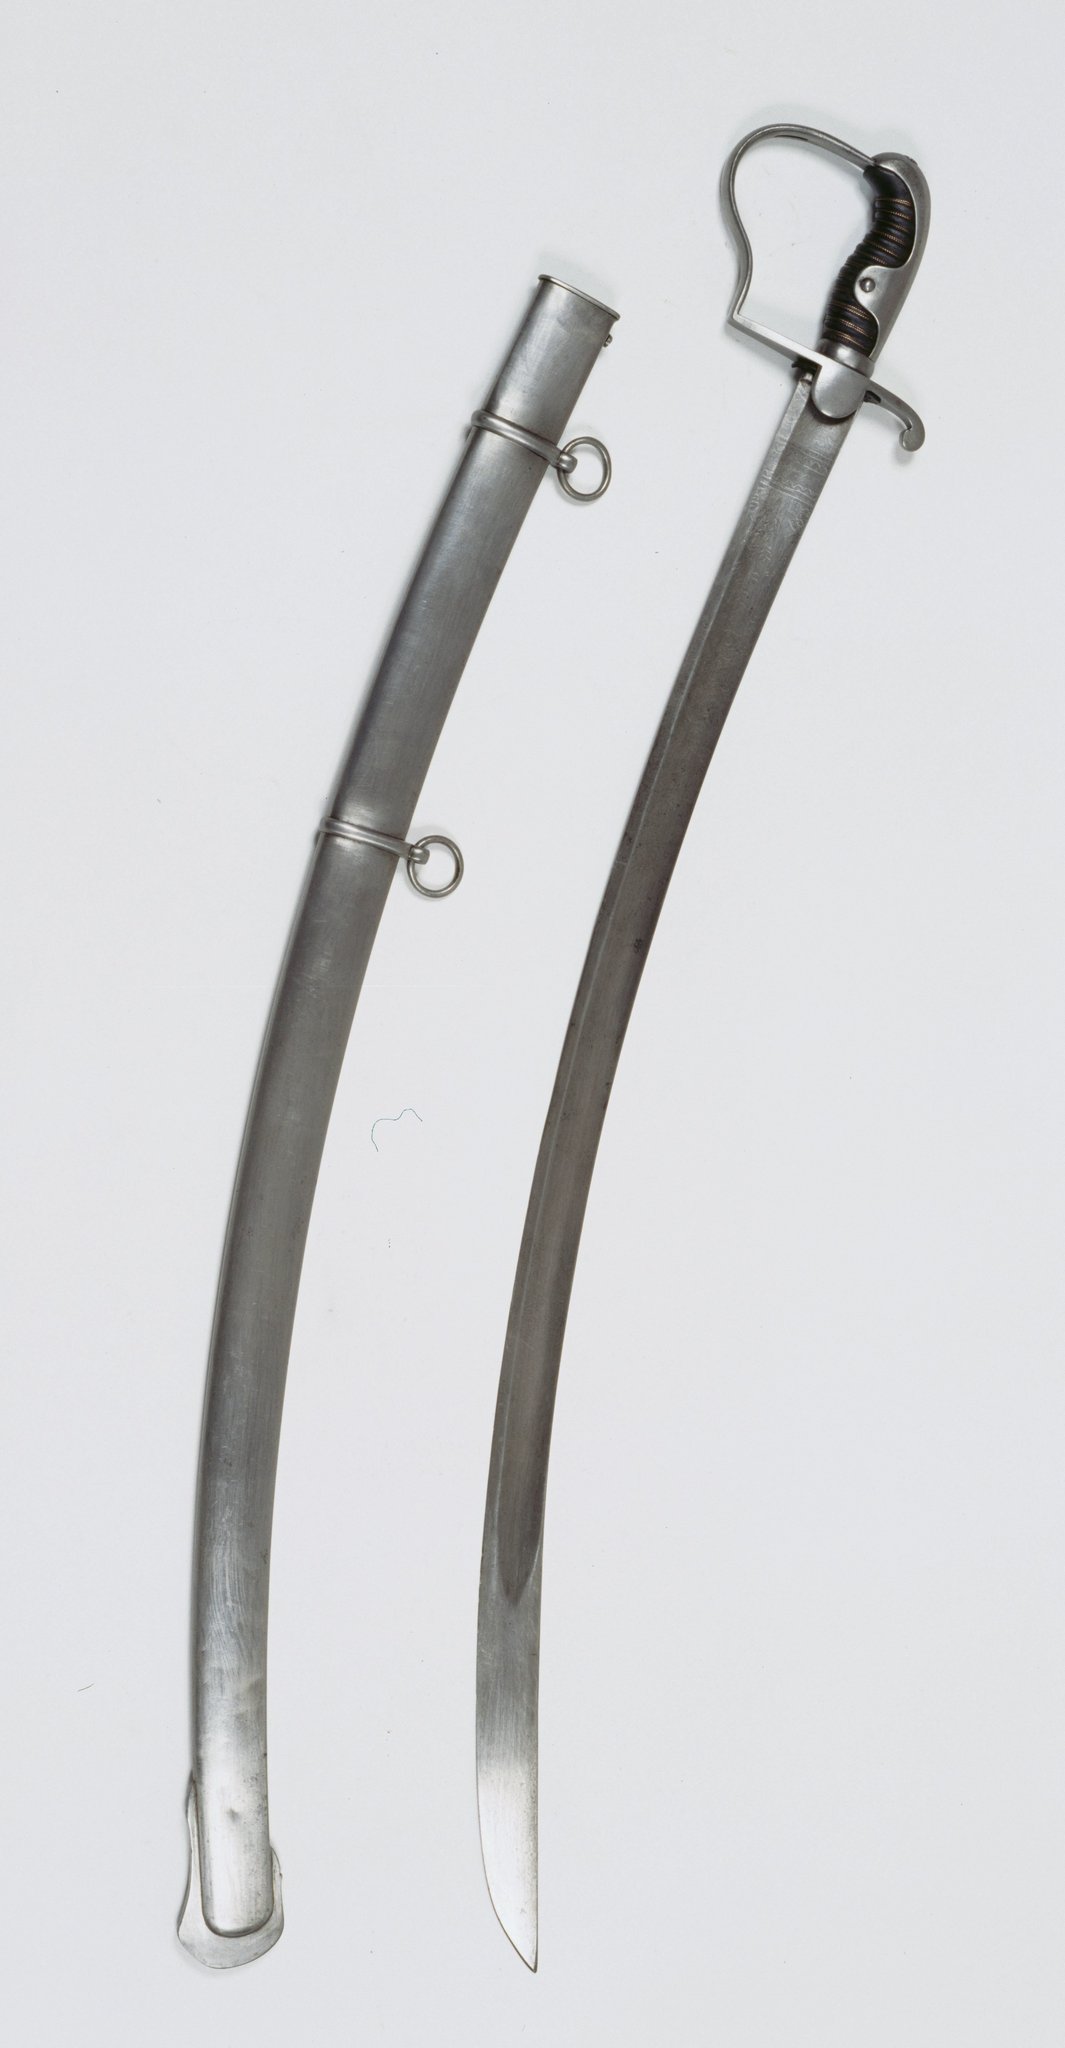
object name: sabre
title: Sabel met schede officieren lichte cavalerie model nr. 1, afkomstig van J.A. de Vos van Steenwijk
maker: peter knecht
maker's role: weapon manufacturer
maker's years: 1798-1852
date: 1798-1852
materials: iron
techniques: etching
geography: solingen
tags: netherlands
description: Officierssabel lichte cavalerie model nr.1. Gevest zonder zijbeugels. Op kling op een zijde opschrift: P. Knecht, op andere zijde: in Solingen. Met twee bijbehorende schedes. Afkomstig van ritmeester J.A. de Vos van Steenwijk.